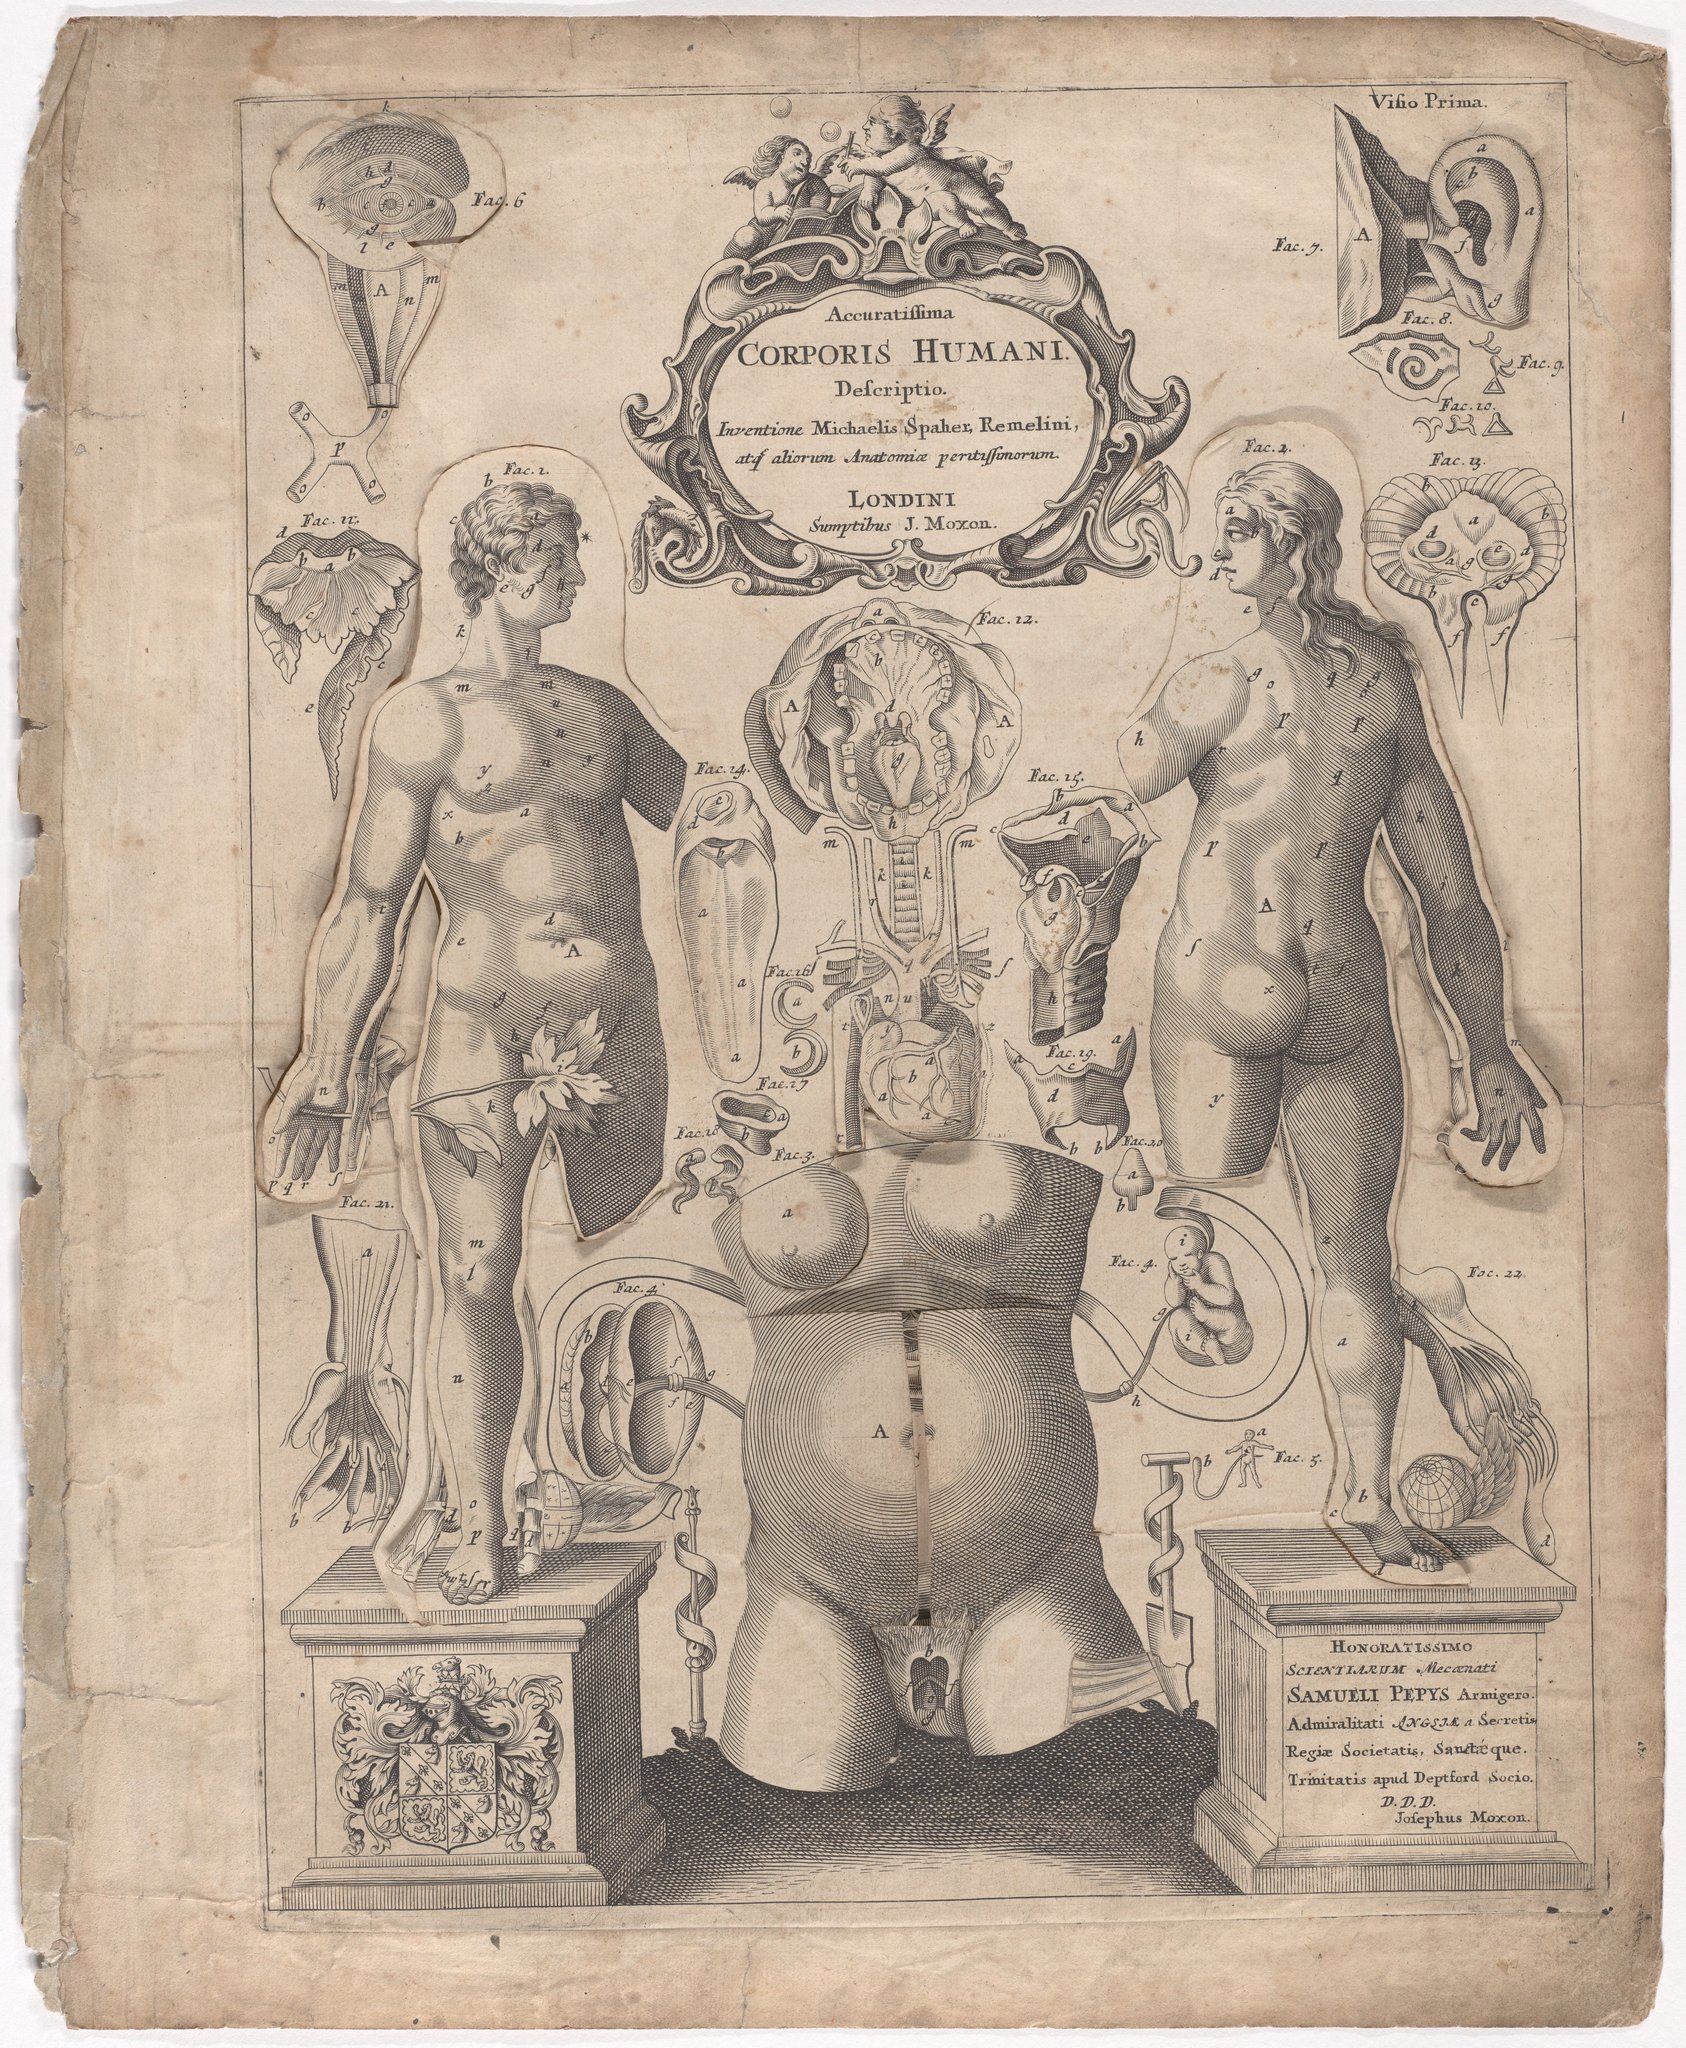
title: A Survey of the Microcosme or the Anatomie of the Bodies of Man and Woman wherein the Skin, Veins, Nerves, Muscles, Bones, Sinews and Ligaments Thereof are Accurately Delineated, and so Disposed by Pasting, as that Each Part of the Said Bodies Both Inward and Outward are Exactly Represented. Useful for all Doctors, Chyrurgeons, Statuaries, Painters, &c.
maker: johann remmelin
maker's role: artist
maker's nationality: german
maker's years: 1583-1632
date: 1675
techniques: engraving, letterpress